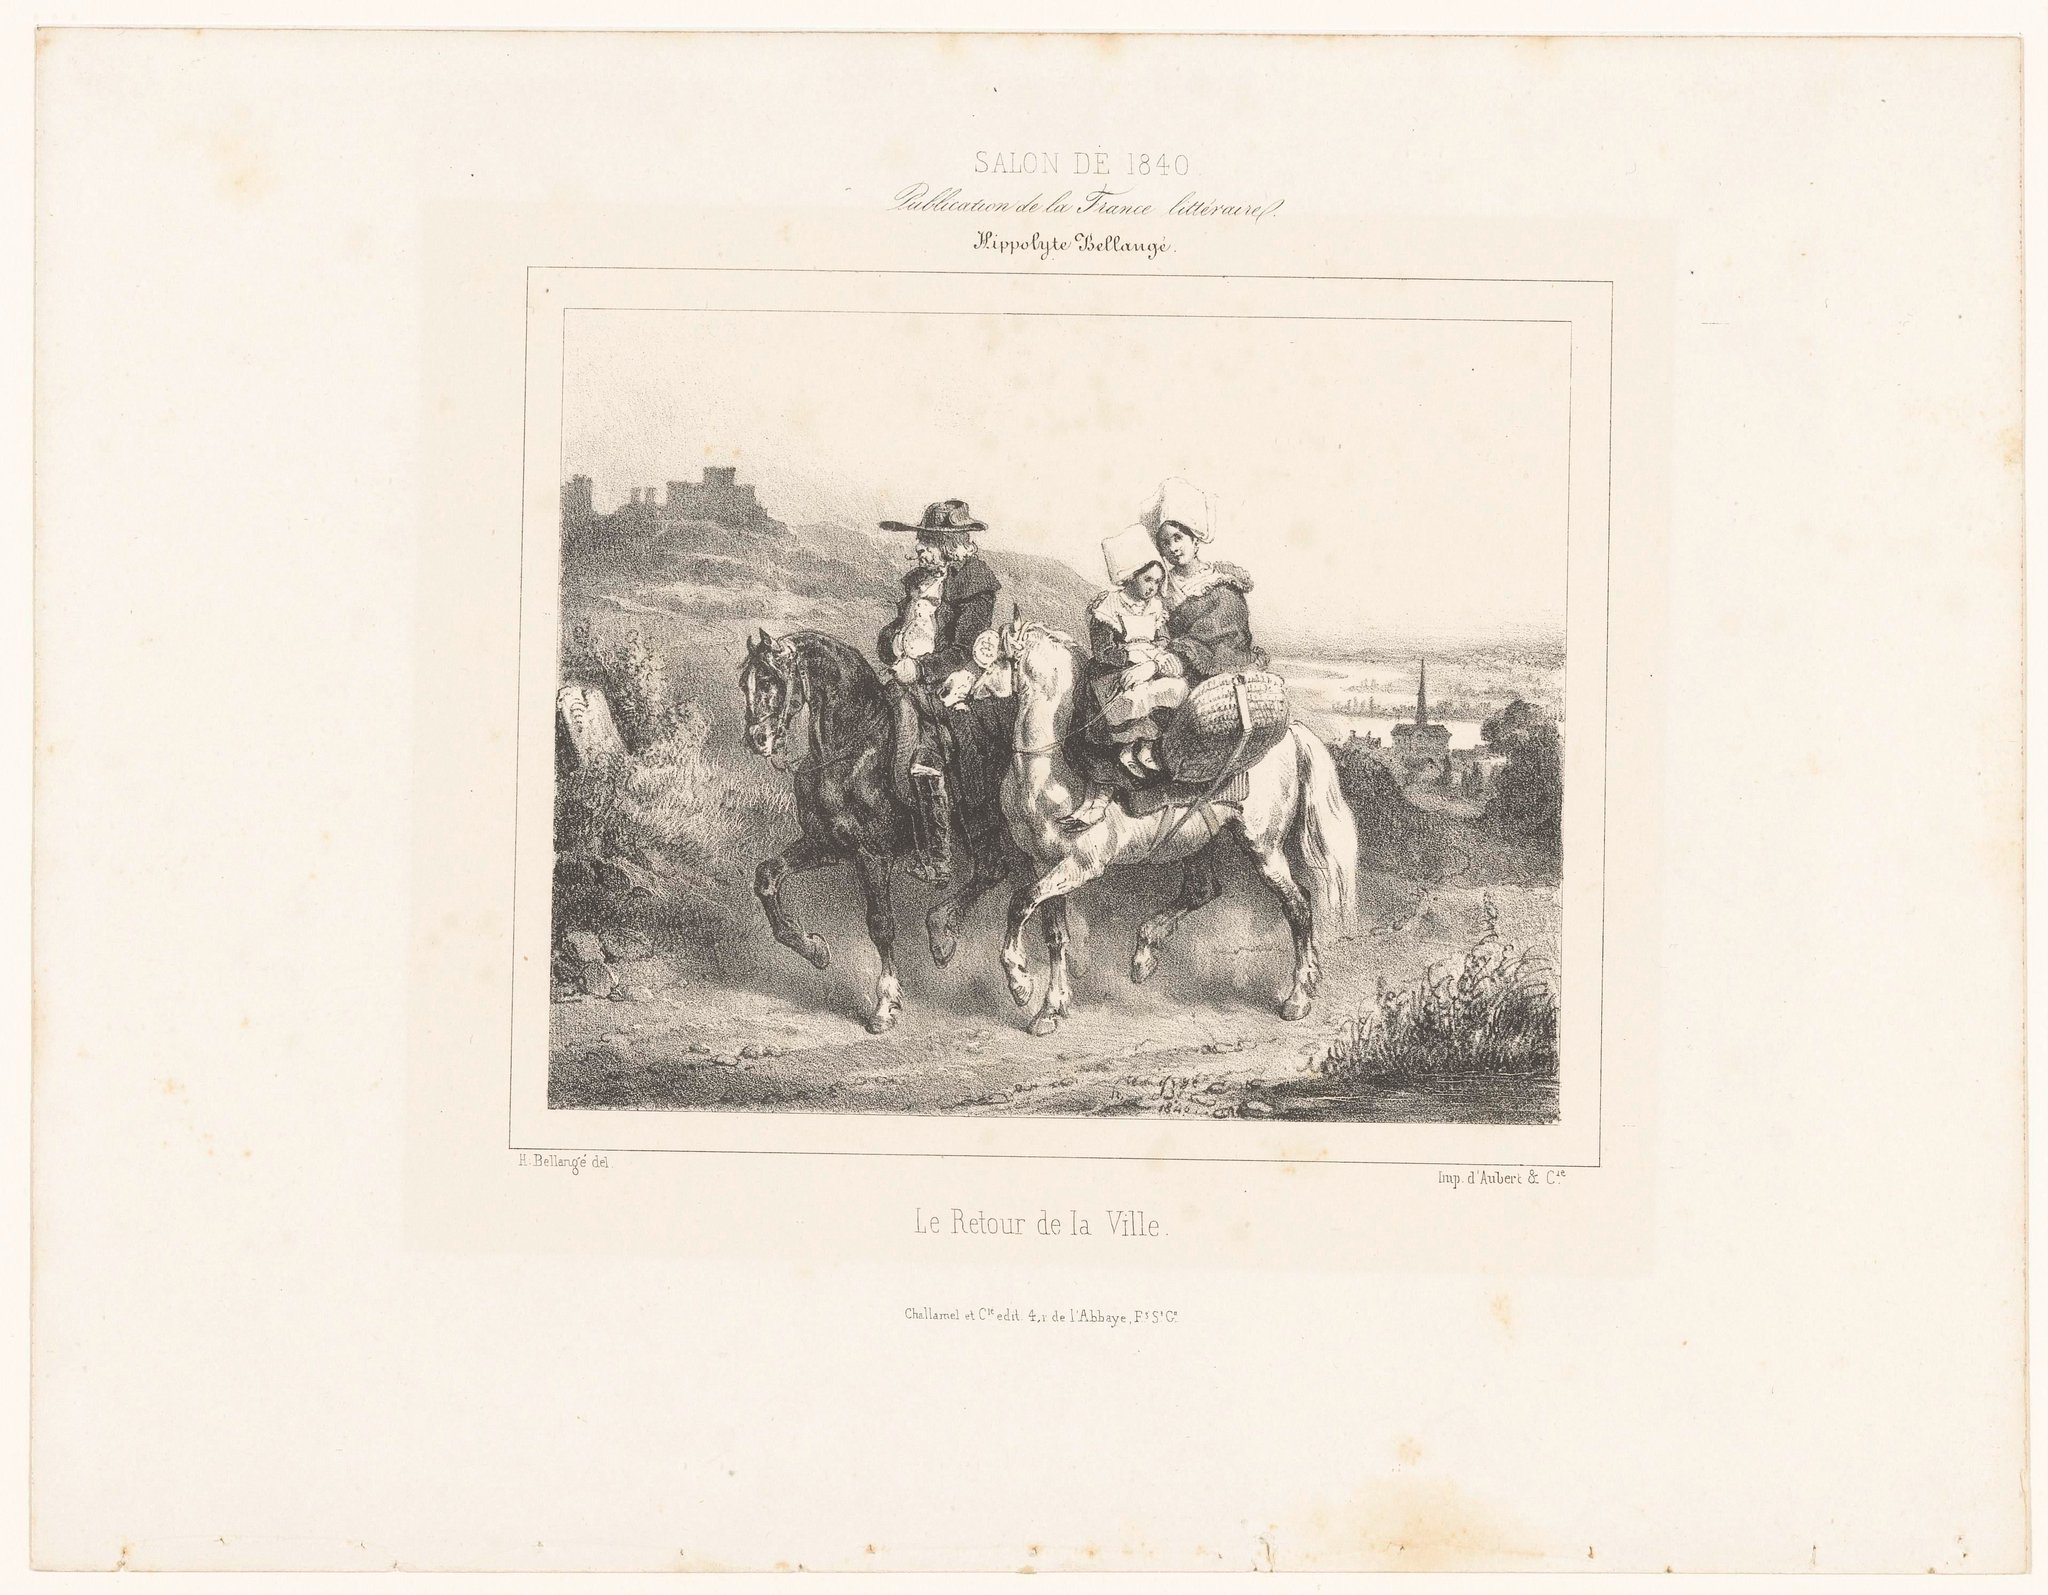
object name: print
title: Gezin keert te paard van de stad terug naar huis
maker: hippolyte bellangé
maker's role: draughtsman, print maker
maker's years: 1800-1866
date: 1840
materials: paper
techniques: lithograph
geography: paris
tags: parents with their children, horse (+ departure and arrival ~ traffic and transport), 'en route', traveller under way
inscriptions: collector's mark: Lugt 2228a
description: Prent gebruikt in: Robert, Jules. Album du Salon de 1840. Collection des principaux ouvrages exposés au Louvre (…). Parijs: Challamel & Cie, 1840. En in: La France littéraire, 1840.